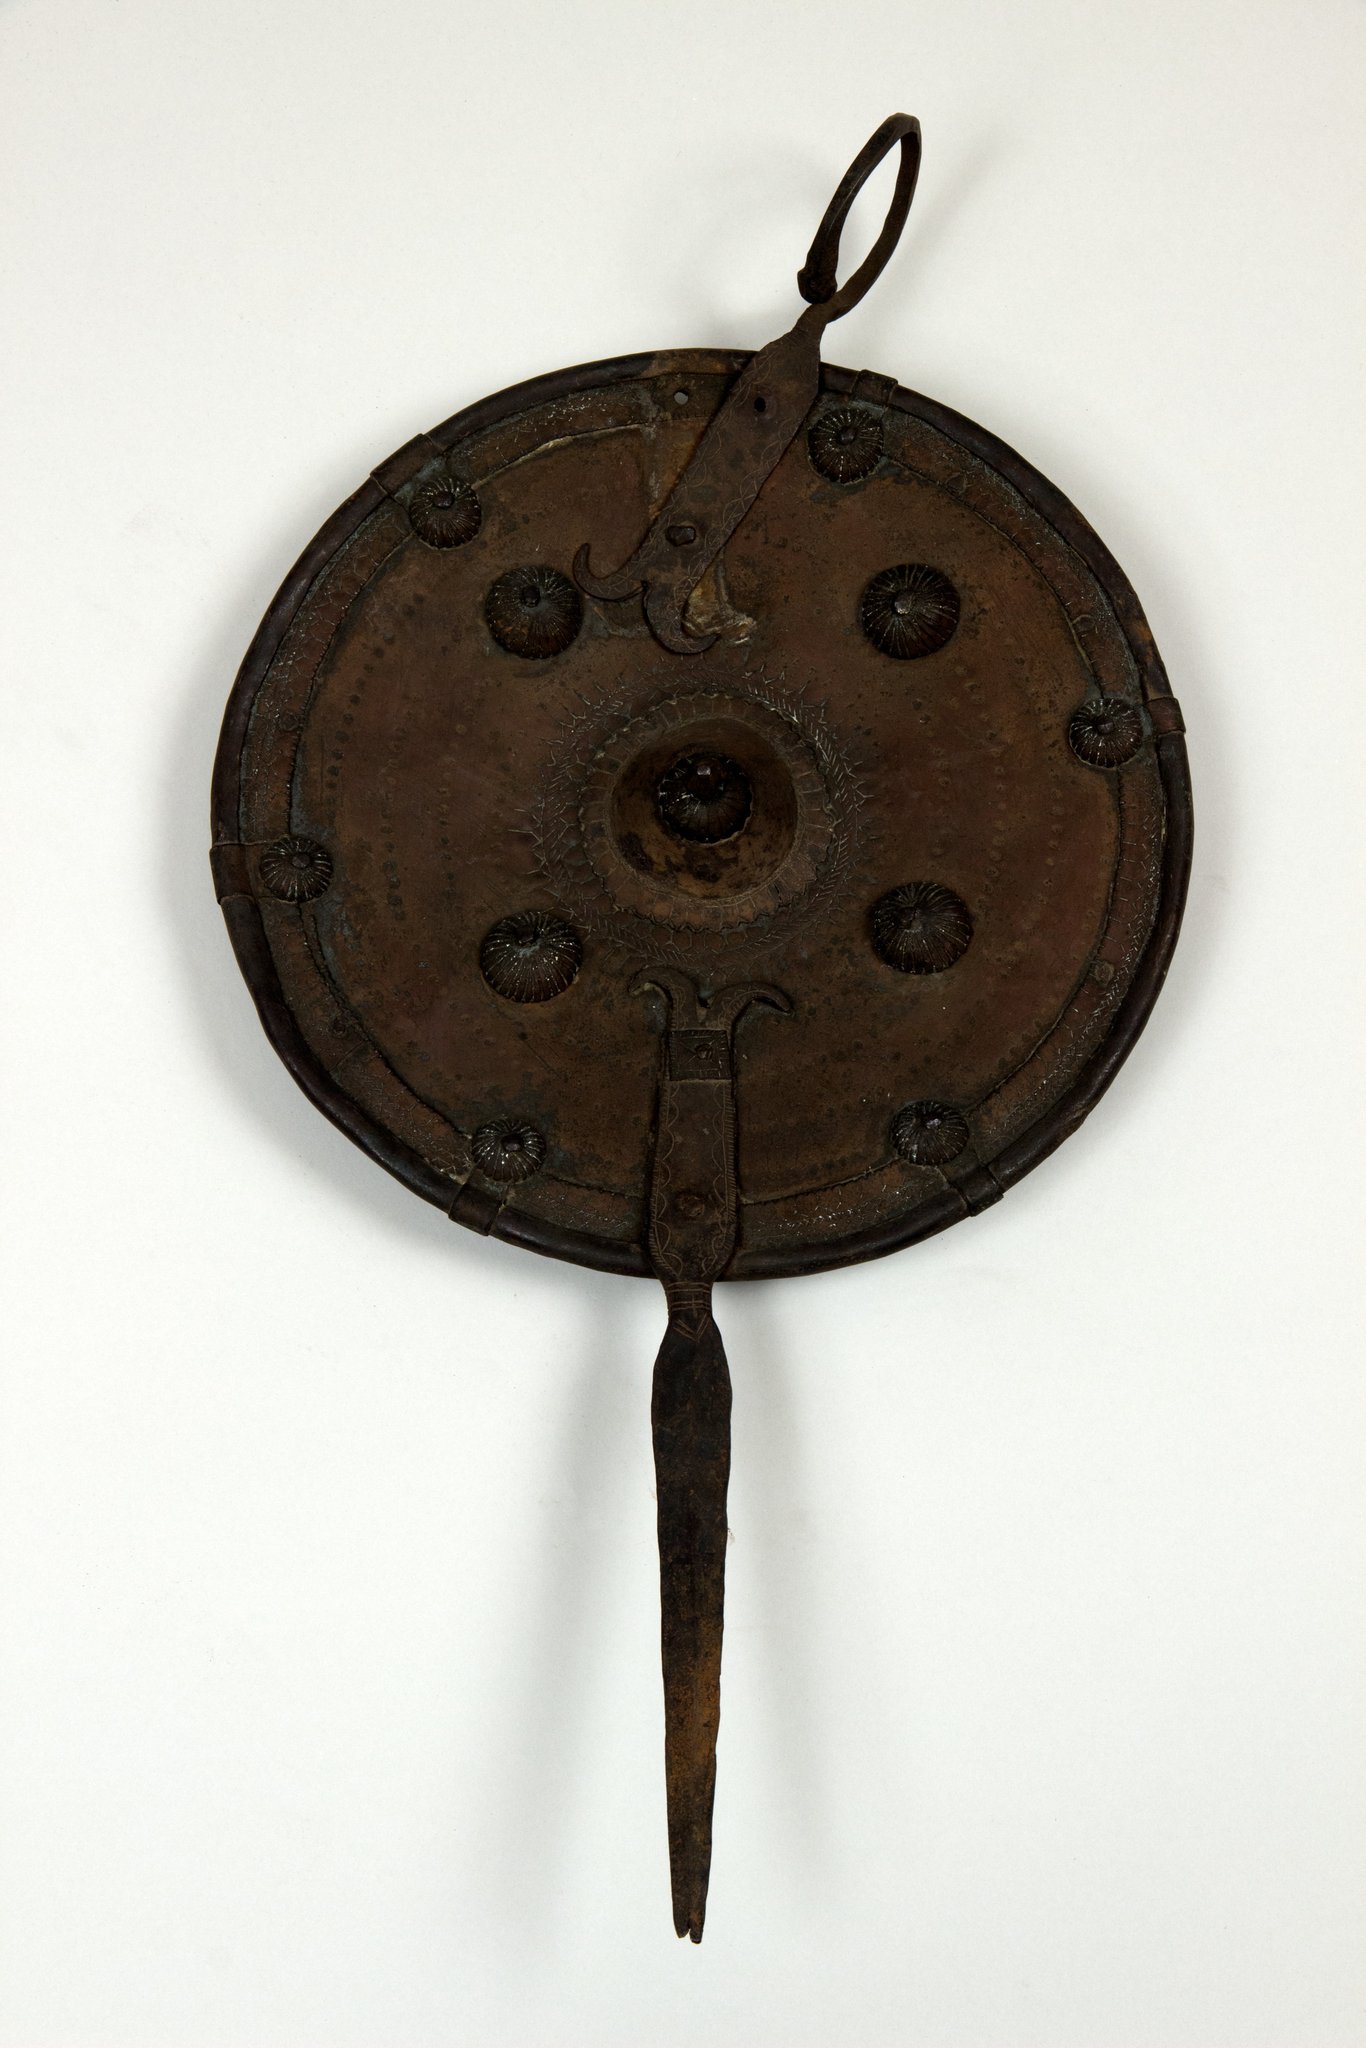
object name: shield dhàl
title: Shield (Dhàl)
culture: indian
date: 1801-1900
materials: copper alloy, hemp, iron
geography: india